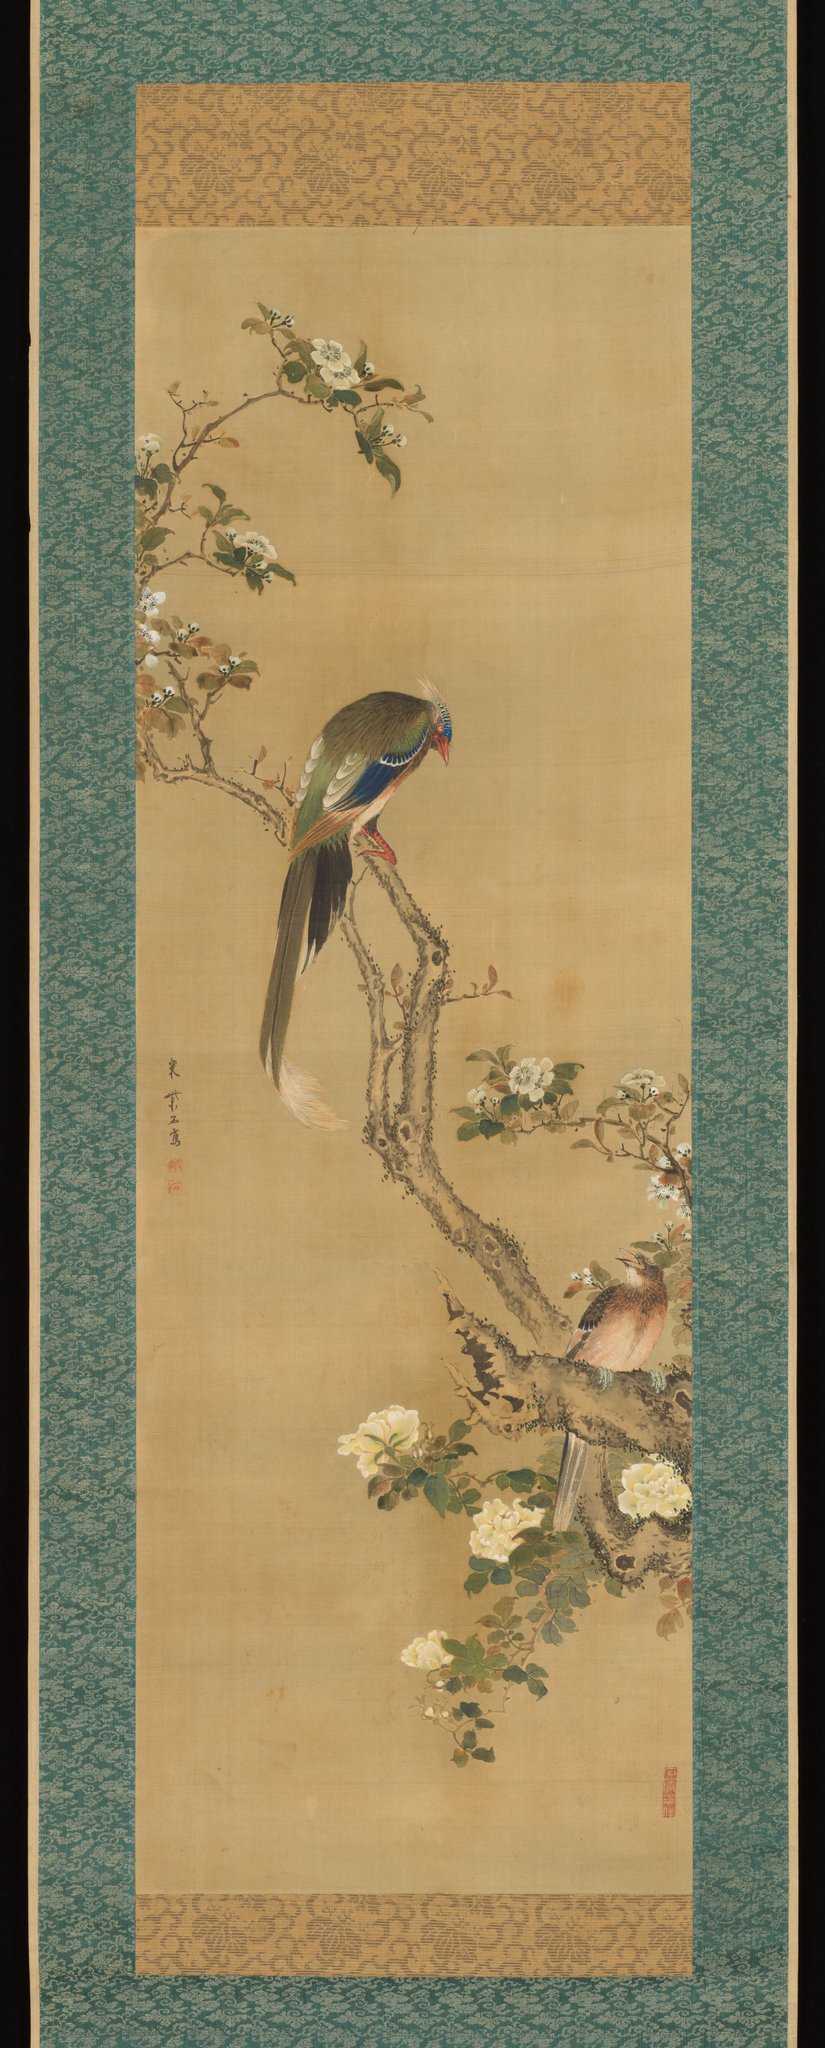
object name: hanging scroll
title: Birds and Flowers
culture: japanese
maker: sō shiseki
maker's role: artist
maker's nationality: japanese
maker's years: 1715-1786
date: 1701-1800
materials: ink, silk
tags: birds,flowers